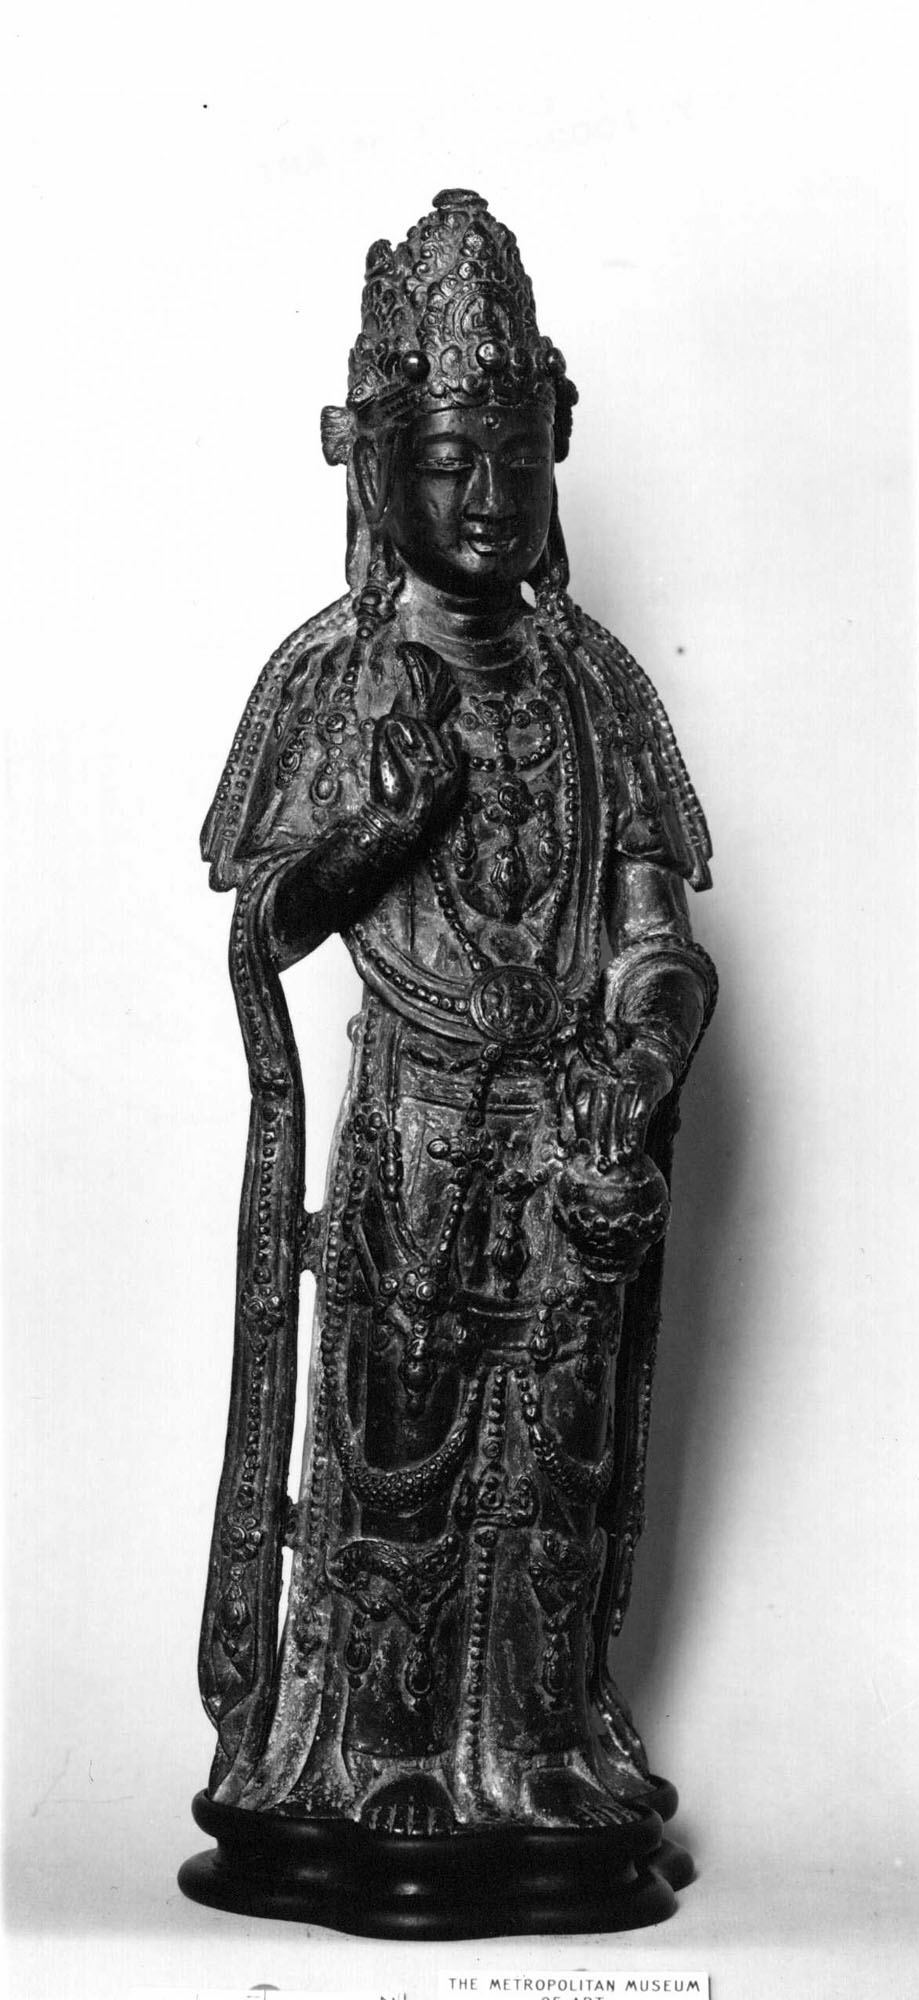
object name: statuette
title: Statuette of Bodhisattva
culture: chinese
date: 934-966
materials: bronze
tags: bodhisattvas